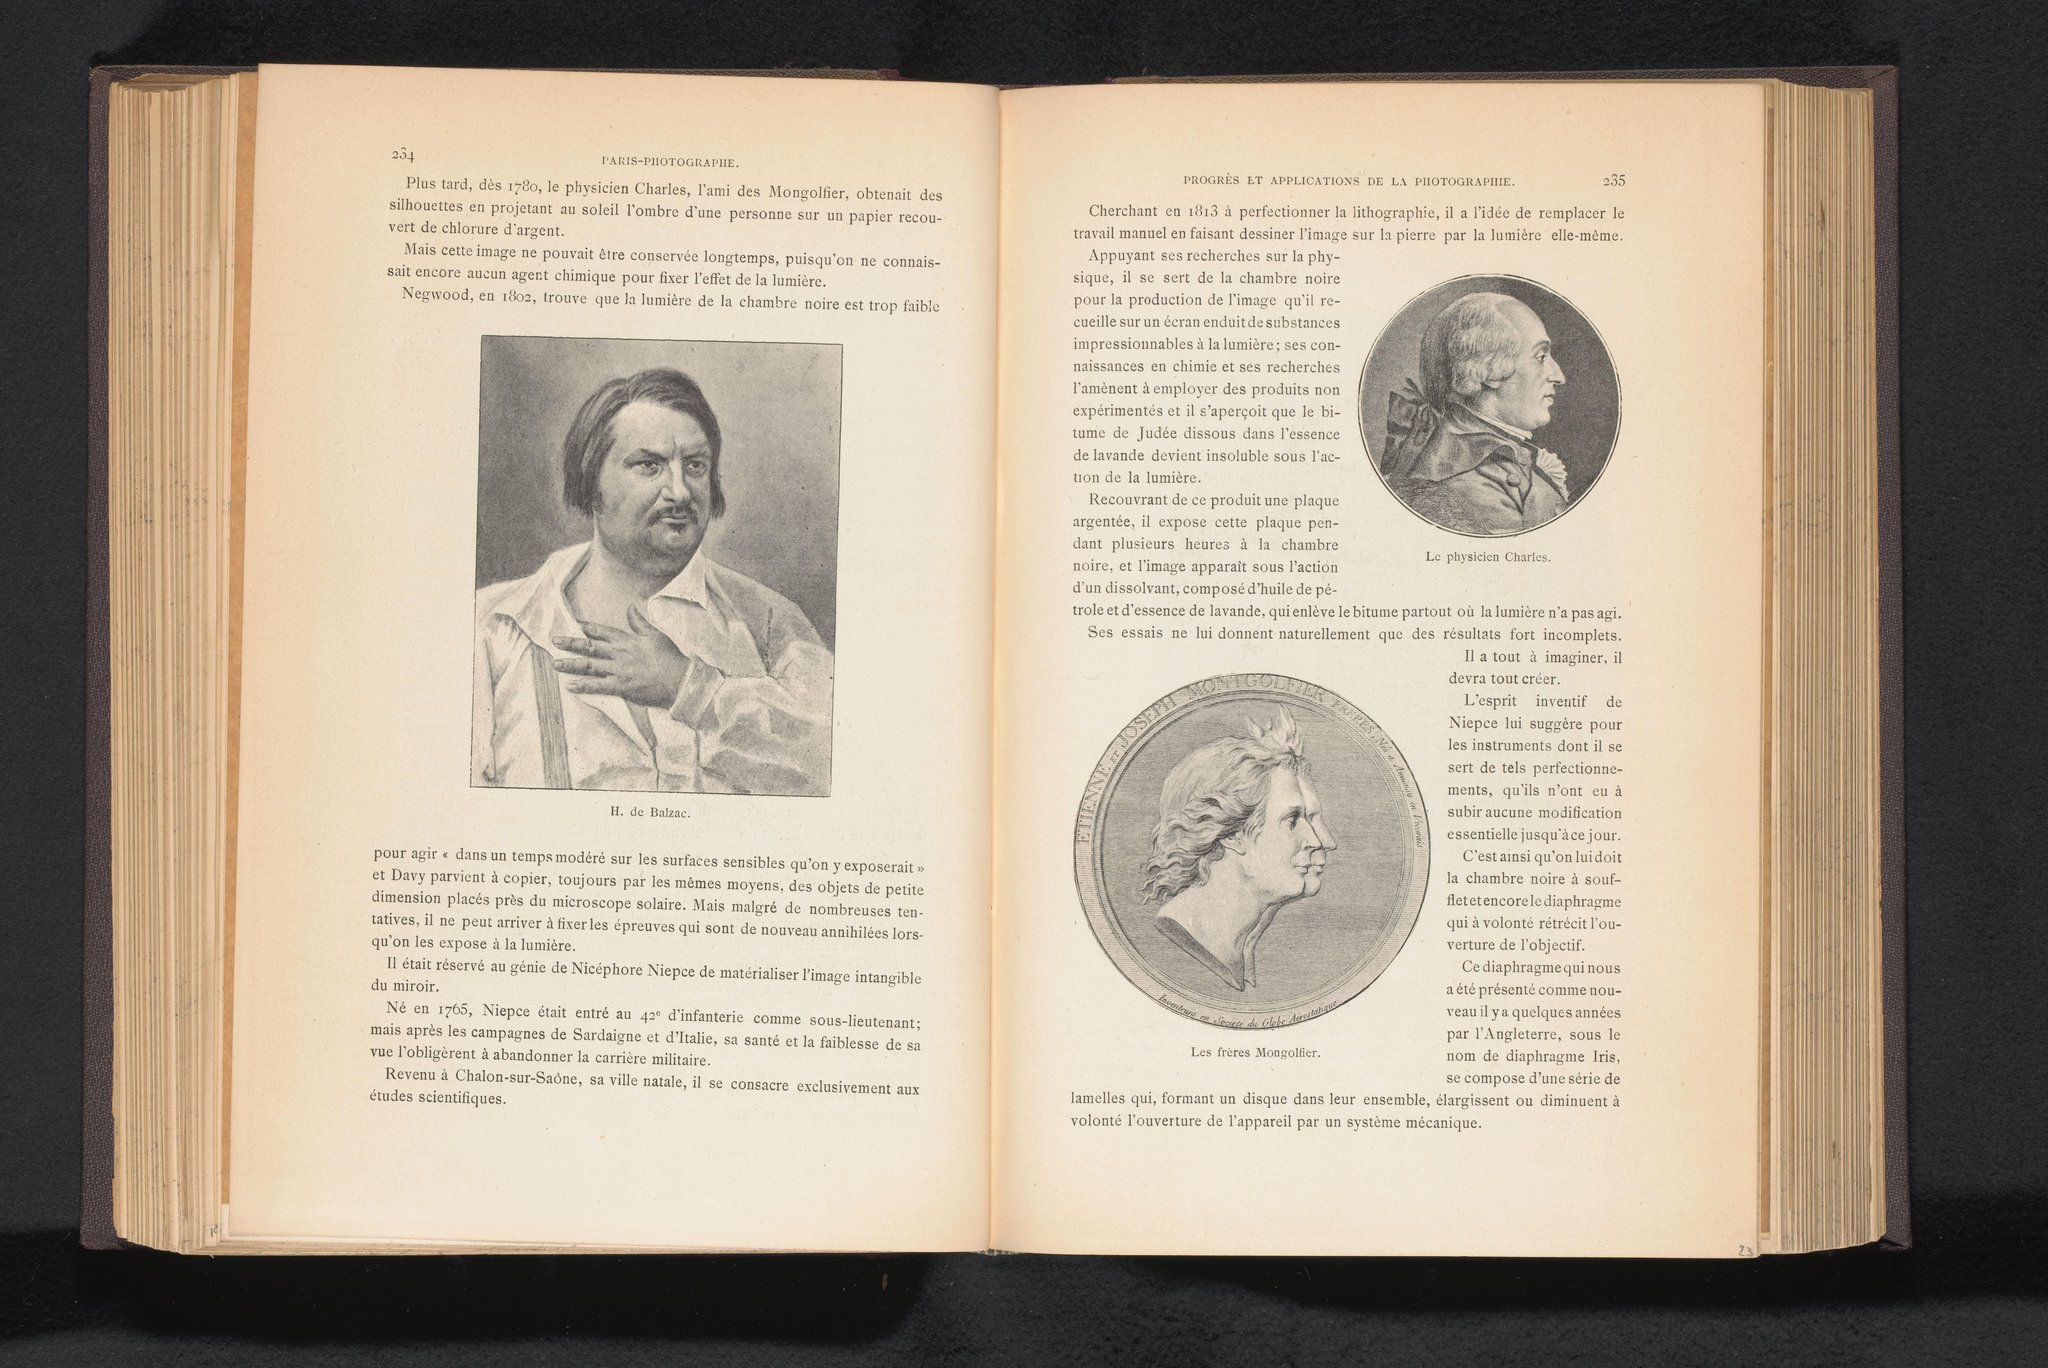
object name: reproduction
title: Le physicien Charles. Les frères Mongolfier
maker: Anonymous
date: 1882-1892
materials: paper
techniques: autotype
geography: france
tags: paris, adult man